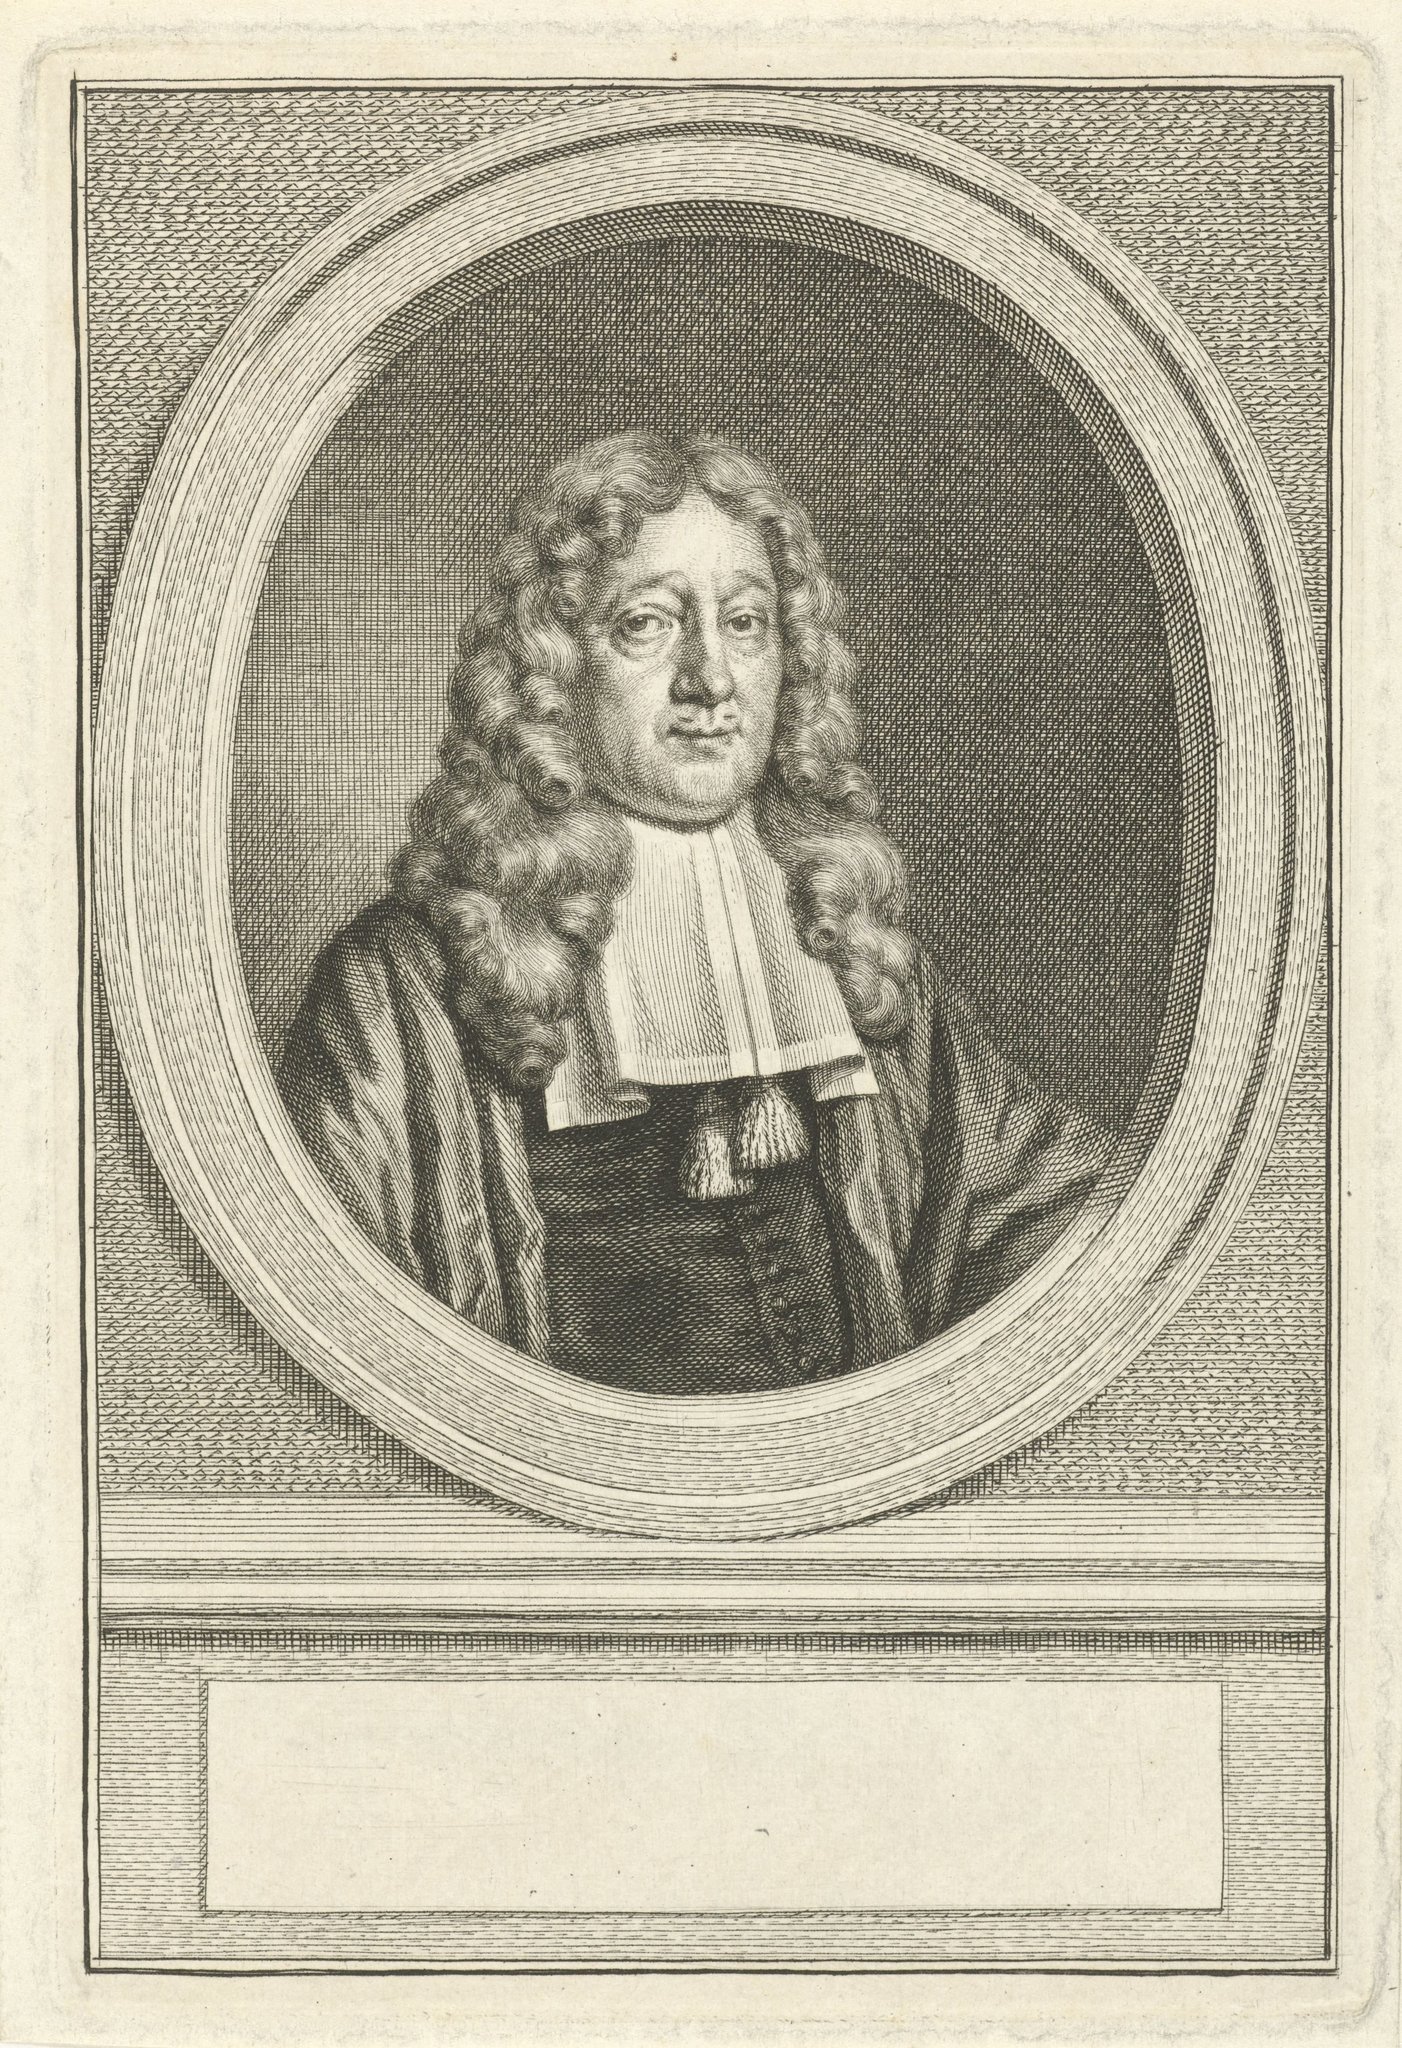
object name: print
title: Portret van Johannes Hudde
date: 1749-1780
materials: paper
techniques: engraving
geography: amsterdam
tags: mayor, johannes hudde, historical persons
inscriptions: collector's mark: Lugt 2228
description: Latere staat van deze prent is oorspronkelijk bedoeld als aanvulling op Jan Wagenaars ‘Vaderlandsche historie’* en was zo vanaf 1796 verkrijgbaar bij Johannes Allart te Amsterdam. Voor de advertentie waarin Allart de 60 portretten en 7 platen, allen gegraveerd door Houbraken, ter aanvulling op Wagenaars ‘Vaderlandsche historie’ aanbiedt, zie RP-P-OB-77.766. *Van dit werk zijn in de achttiende eeuw meerdere uitgaves verschenen, zoals: Wagenaar, Jan. Vaderlandsche historie, vervattende de geschiedenissen der Vereenigde Nederlanden (…). 21 delen. Amsterdam: Isaak Tirion, 1749-1759. Wagenaar, Jan. Vaderlandsche historie, vervattende de geschiedenissen der nu Vereenigde Nederlanden (…). 21 delen. Amsterdam: weduwe Isaak Tirion, 1770. Wagenaar, Jan. Vaderlandsche historie, vervattende de geschiedenissen der nu Vereenigde Nederlanden (…). 21 delen. Amsterdam, Leiden, Dordrecht en Harlingen: P. Schouten e.a., 1782. Wagenaar, Jan. Vaderlandsche historie, vervattende de geschiedenissen der nu Vereenigde Nederlanden (…). 21 delen. Amsterdam: Johannes Allart, 1790-1796.